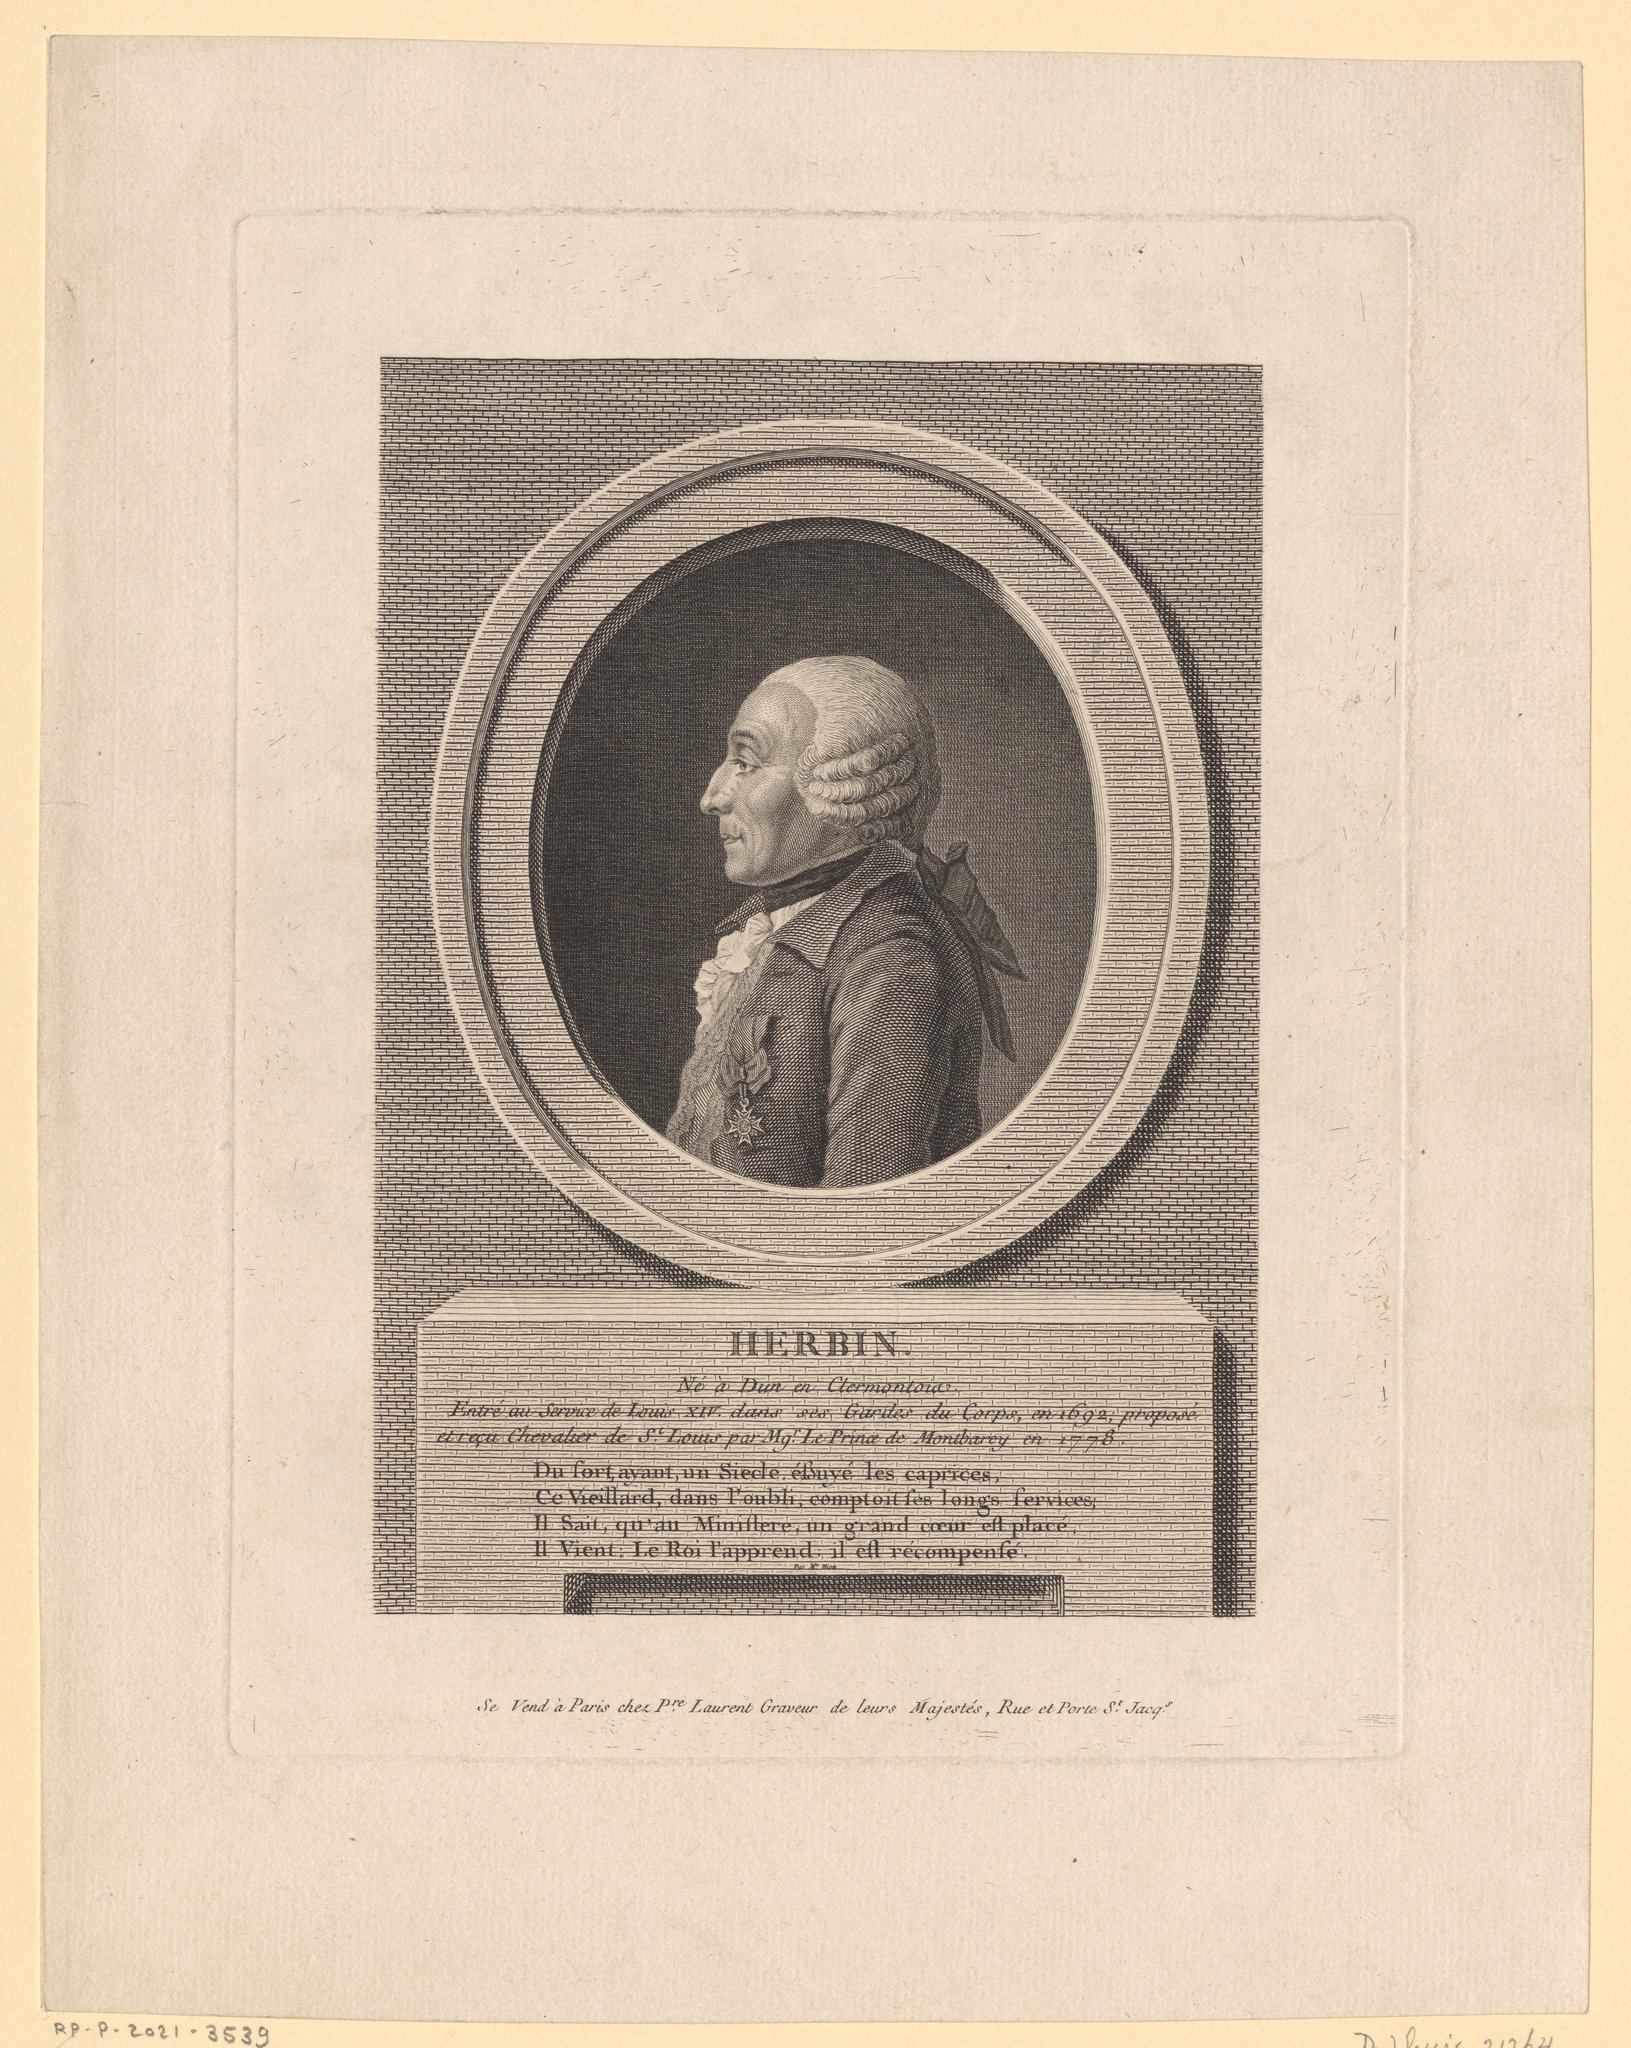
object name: print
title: Portret van Herbin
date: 1778-1799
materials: paper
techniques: engraving, etching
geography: paris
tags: historical persons, body-guard of ruler